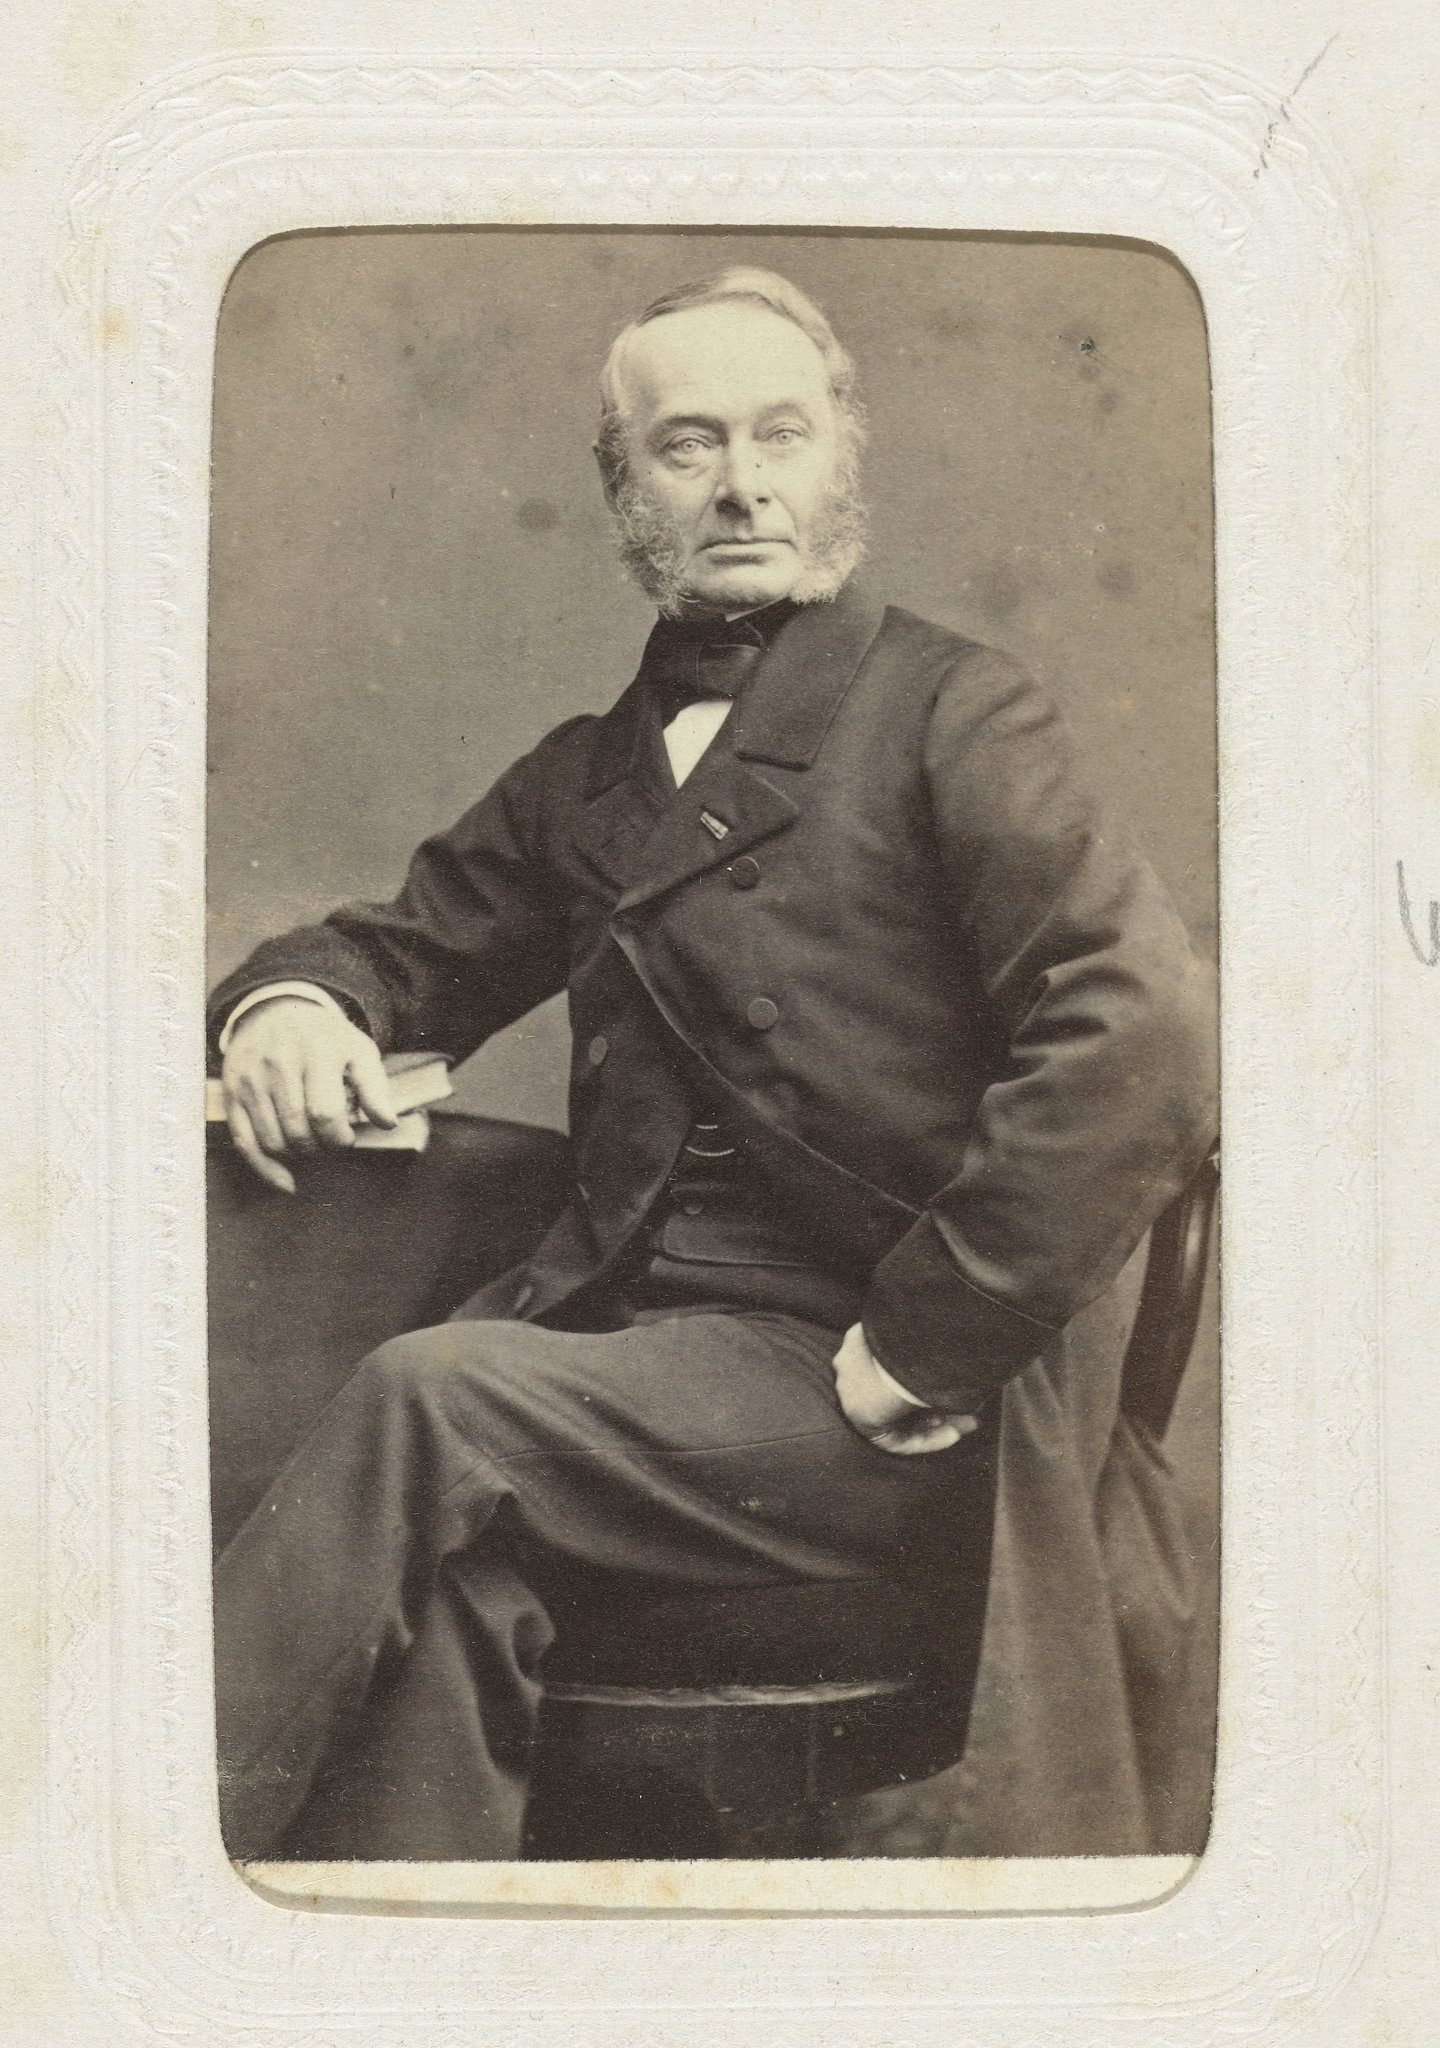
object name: carte de visite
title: Studioportret van een man met grote bakkebaarden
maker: Anonymous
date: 1863-1866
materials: cardboard, paper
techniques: albumen print